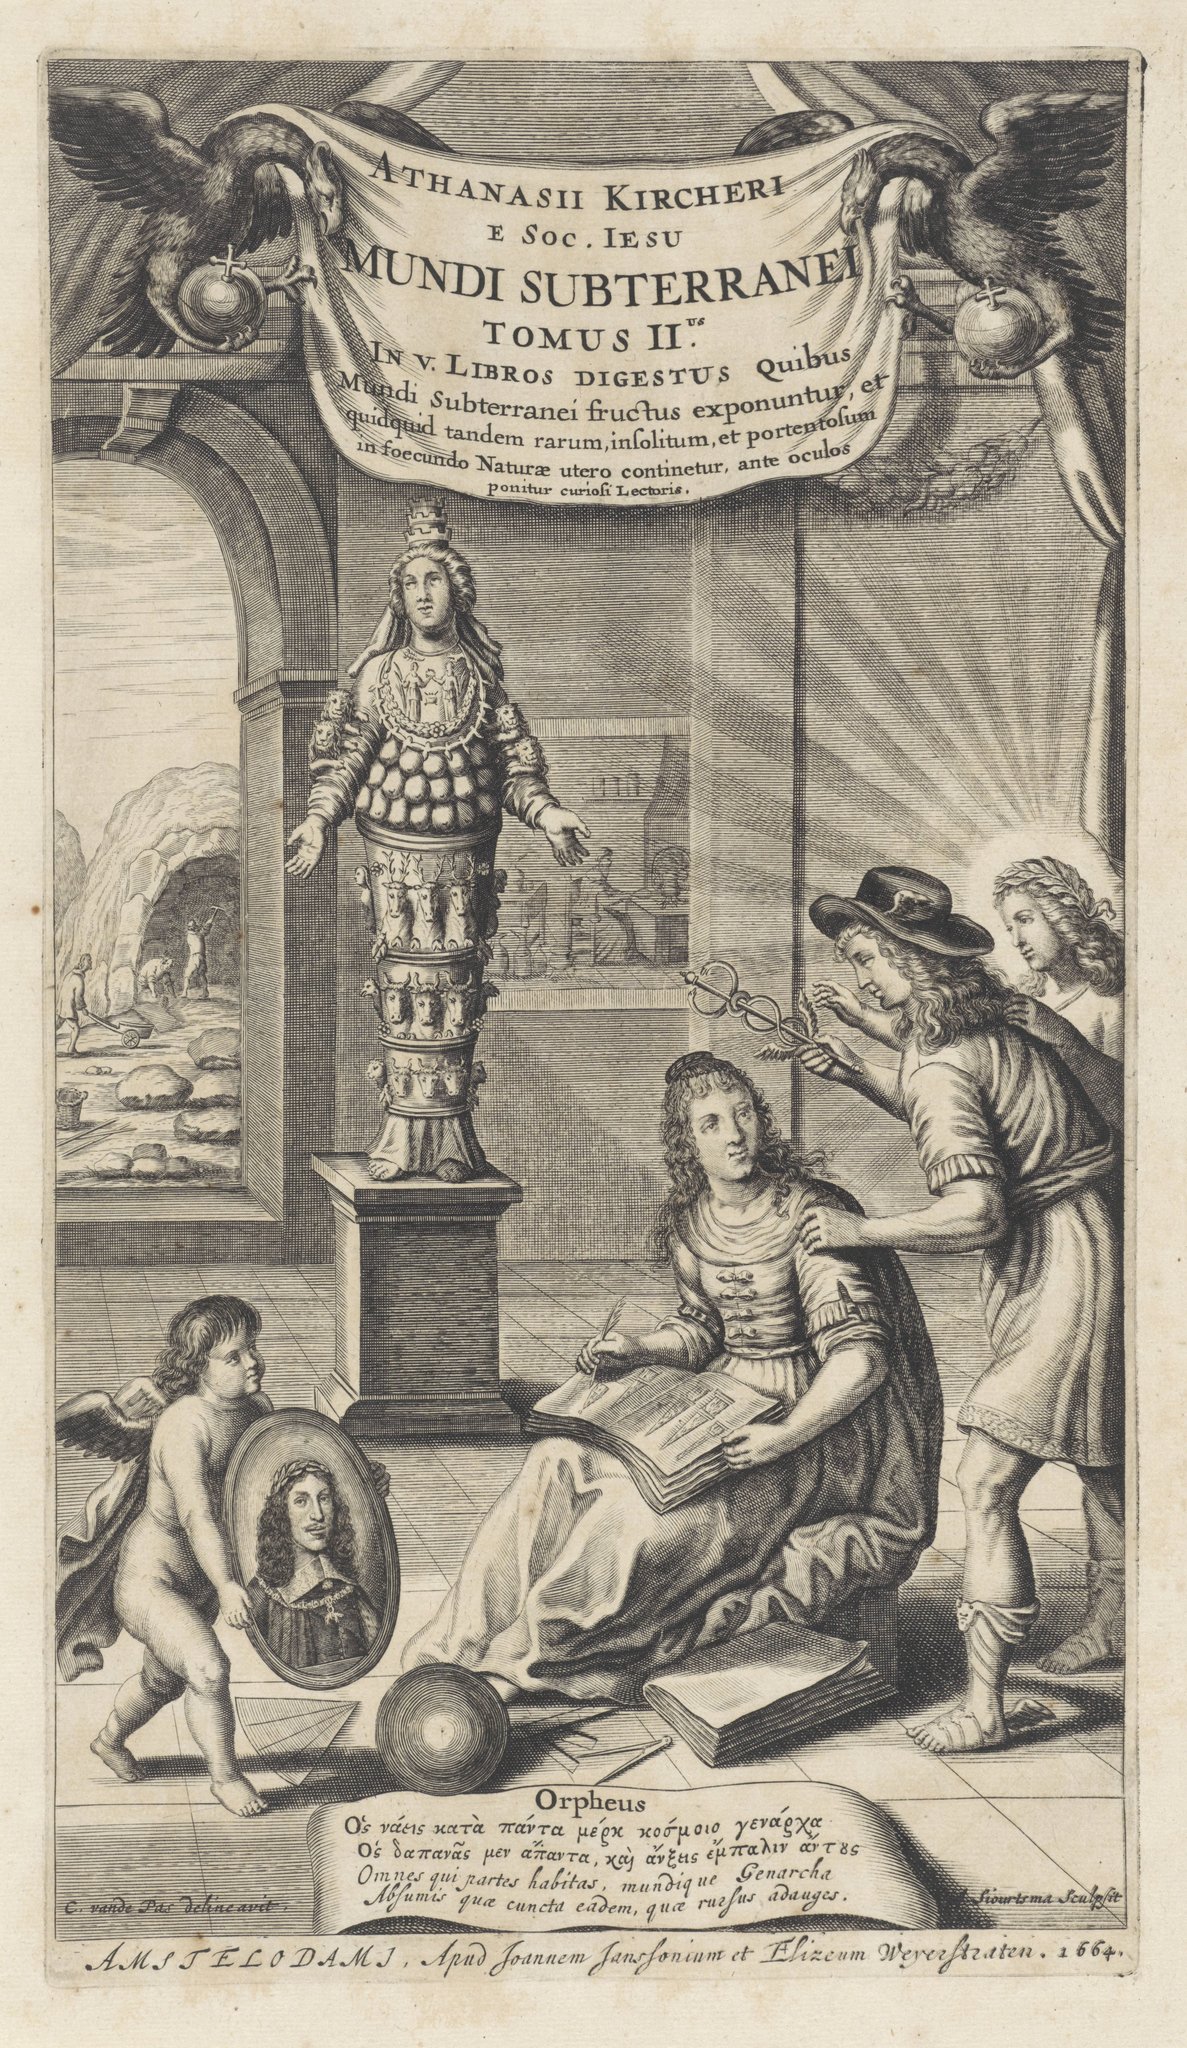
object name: titelblad, titelpagina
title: Titelpagina voor: A. Kircher, Mundus subterraneus, 2e deel, 1664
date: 1664-1665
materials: paper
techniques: engraving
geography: amsterdam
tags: rome, vienna, leopold i (keizer van duitsland), 'natura' (allegorical figure or scene; or as diana of ephesus, with many breasts); 'natura' (ripa), opencast mine; strip mining, obelisk, needle, (story of) mercury (hermes), apollo as sun-god, i.e. sol (helius), titan, measuring-instruments, alchemist at work, book in which illustrations are essential - mm - book open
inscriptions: collector's mark: Lugt 2228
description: Een vrouw zit op een krukje en schrijft in een boek met afbeeldingen van obelisken. Naast haar op de grond liggen meetinstrumenten en een tweede boek. Mercurius en Apollo buigen zich over haar heen. Een putto houdt een portret vast van keizer Leopold I. Op een sokkel staat een standbeeld van Diana van Efeze. Aan de muur hangt een afbeelding van een alchemistische werkplaats. Door een raam is er zicht op mannen die in een mijn werken. Twee adelaars die een rijksappel in hun poten dragen houden een draperie omhoog, waarop de titel van het boek staat. Onderaan de prent staan twee Griekse versregels met hun vertaling in het Latijn op Orpheus, de dichter die na de dood van zijn geliefde Eurydice afdaalde in de onderwereld.